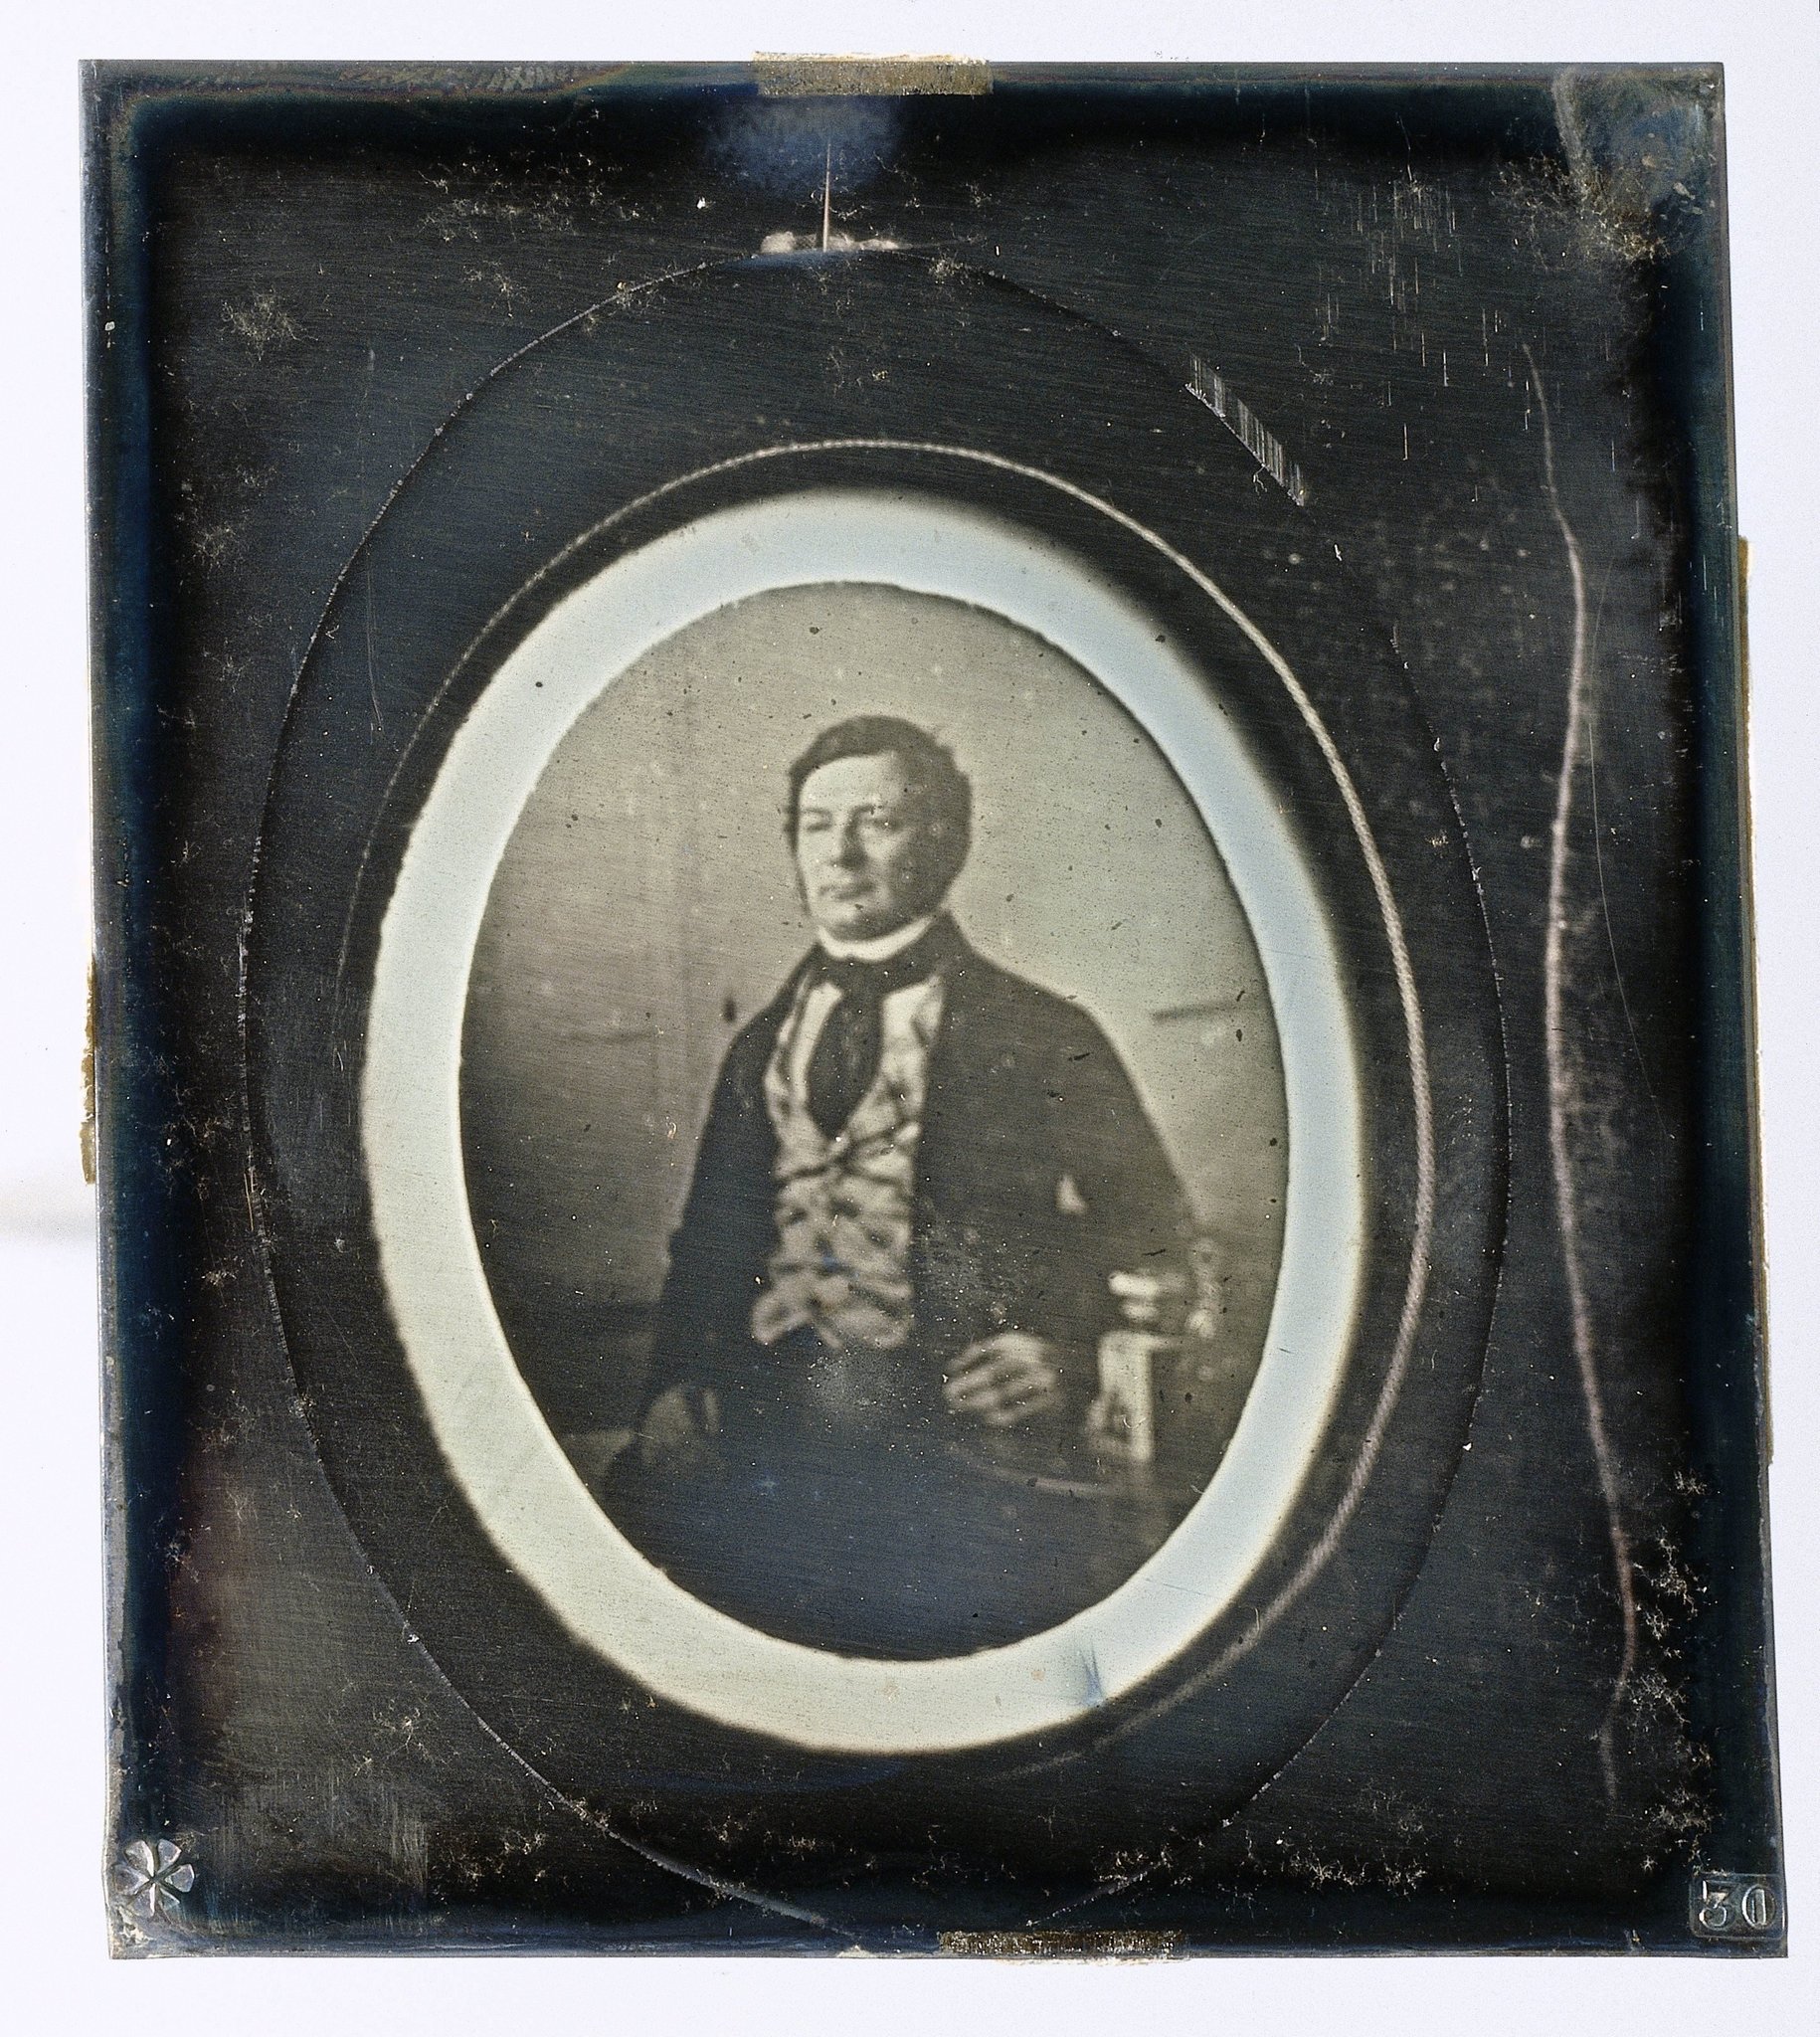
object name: photograph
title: Reproductie van een portret van Louis Asser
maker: eduard isaac asser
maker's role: amateurfotograaf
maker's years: 1809-1894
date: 1850-1860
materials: copper, glass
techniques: daguerreotype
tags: netherlands